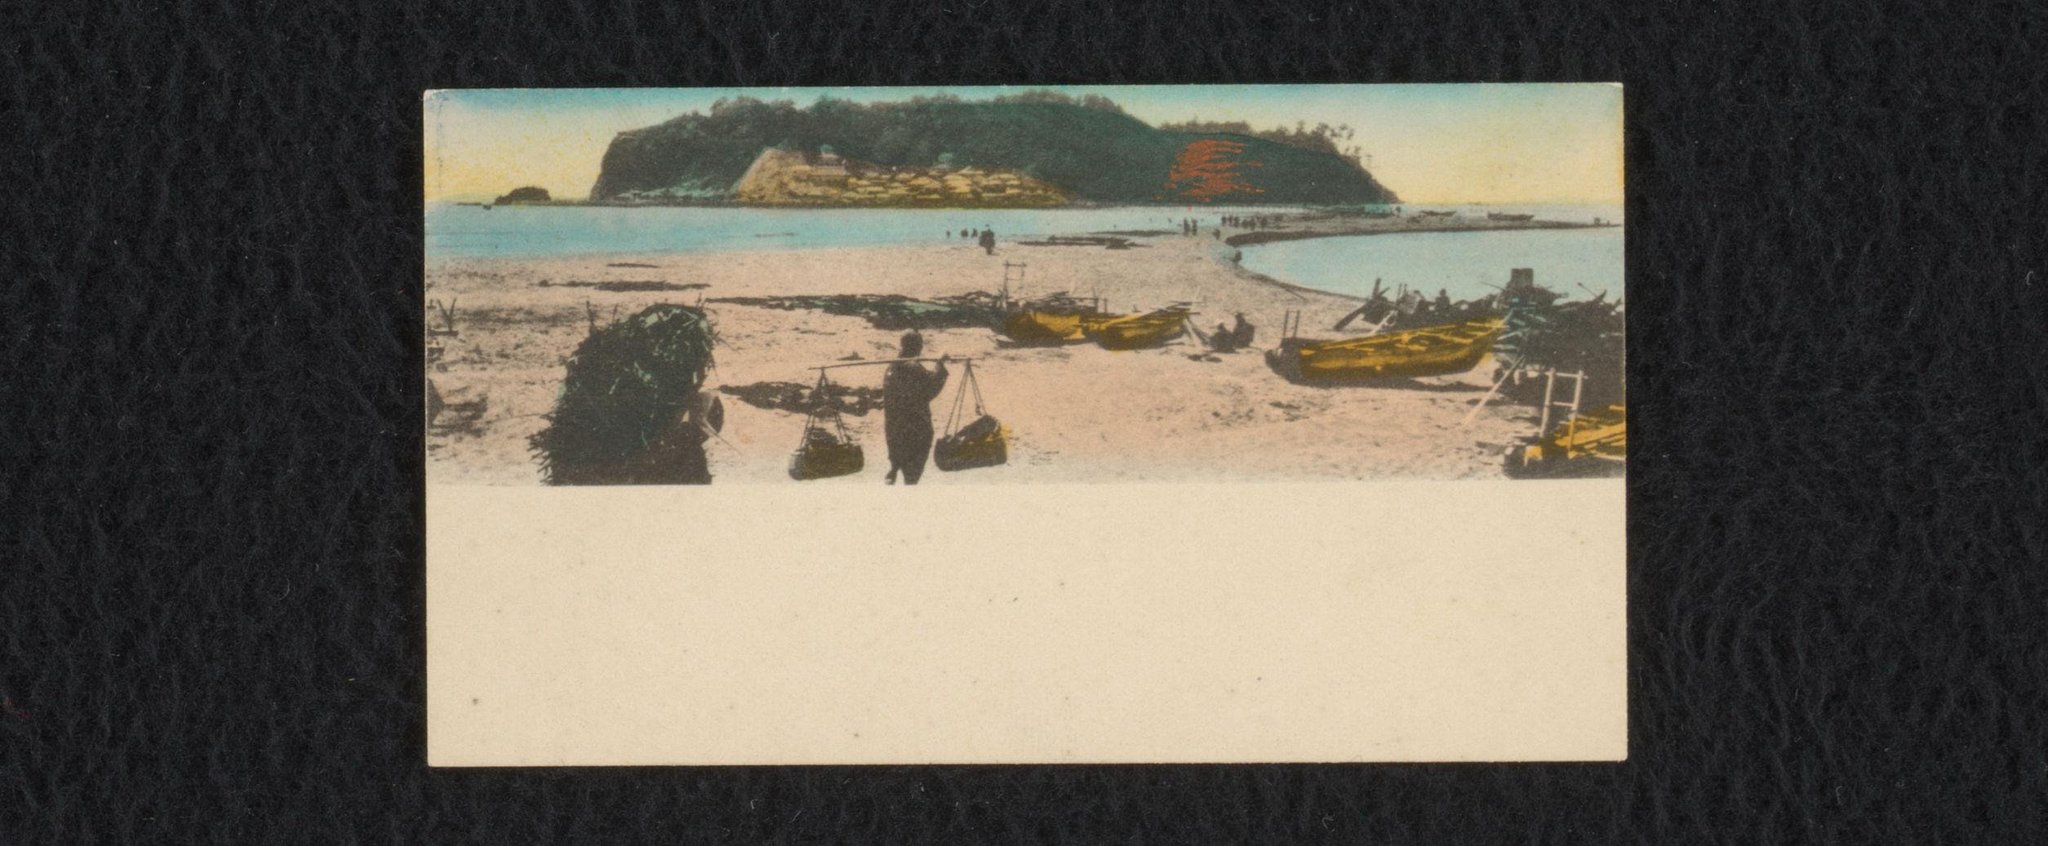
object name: photomechanical print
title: Strand met boten in Japan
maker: Anonymous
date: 1890-1920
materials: paper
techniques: photograph, lithograph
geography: japan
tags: rowing-boat, canoe, etc., japan